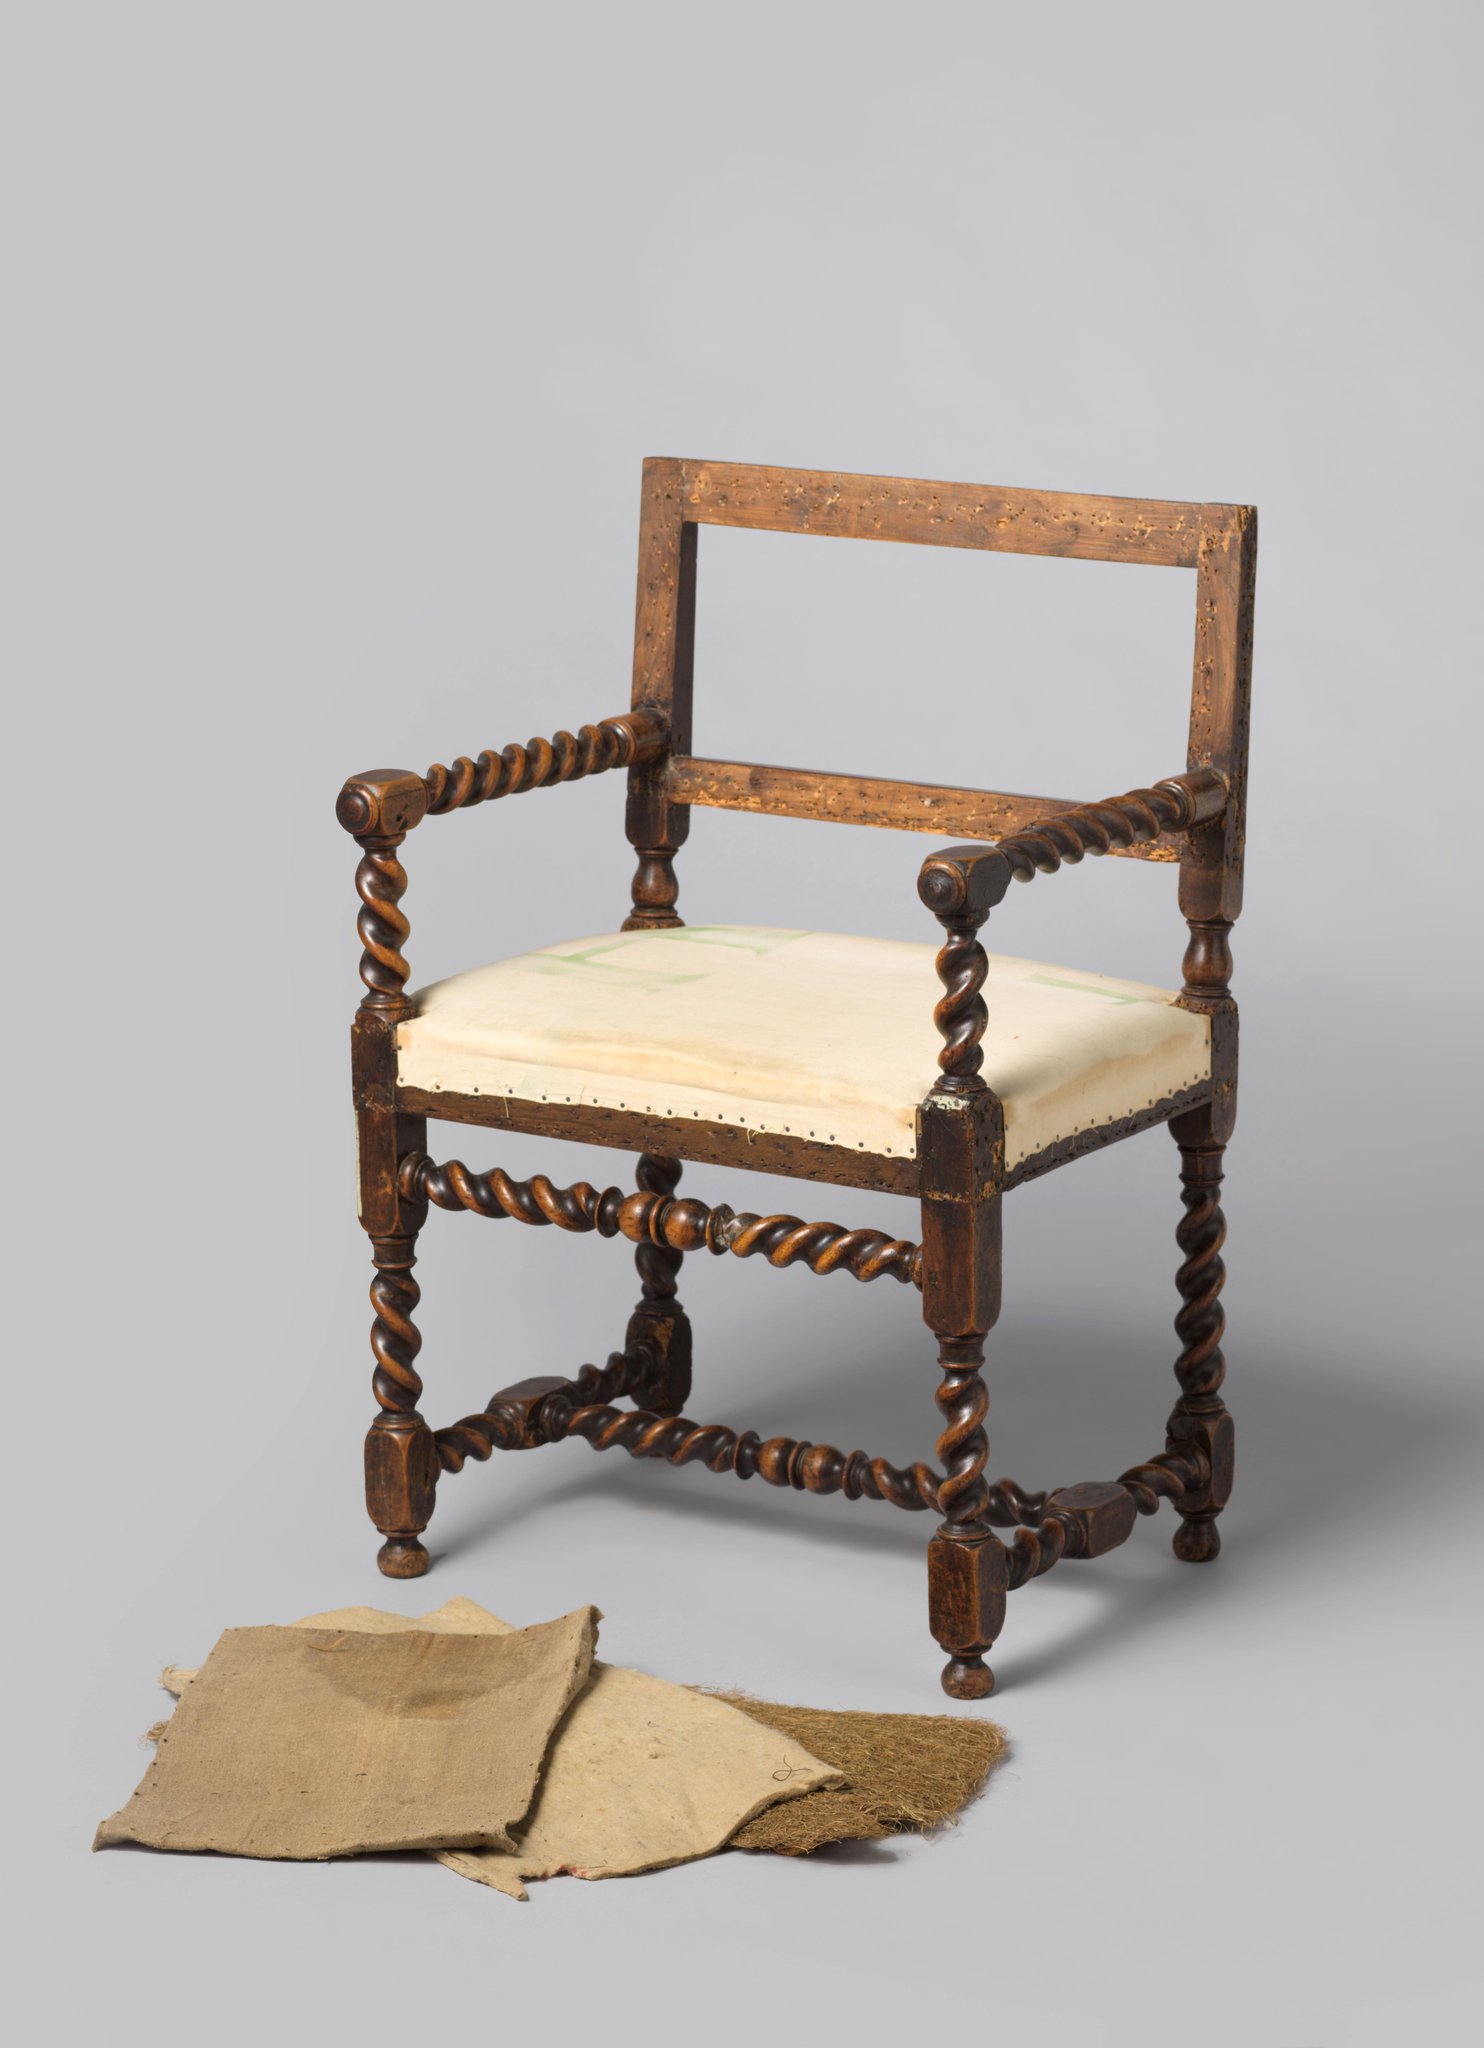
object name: furniture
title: Stoel in neo renaissance-stijl met geslingerde onderdelen en met beklede zitting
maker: Anonymous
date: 1880-1920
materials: textile, wood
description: Armstoel behorende tot een set van drie stoelen en een armstoel van notenhout met een beklede zitting. De geslingerde poten zijn verbonden door een geslingerd H-vormig kruis en een eveneens geslingerde voorsport. Het beklede rugraam rust op gelede stutten. De leunstoel heeft geslingerde armleggerstutten en armleggers. Zie: BK-1959-116-a/d.